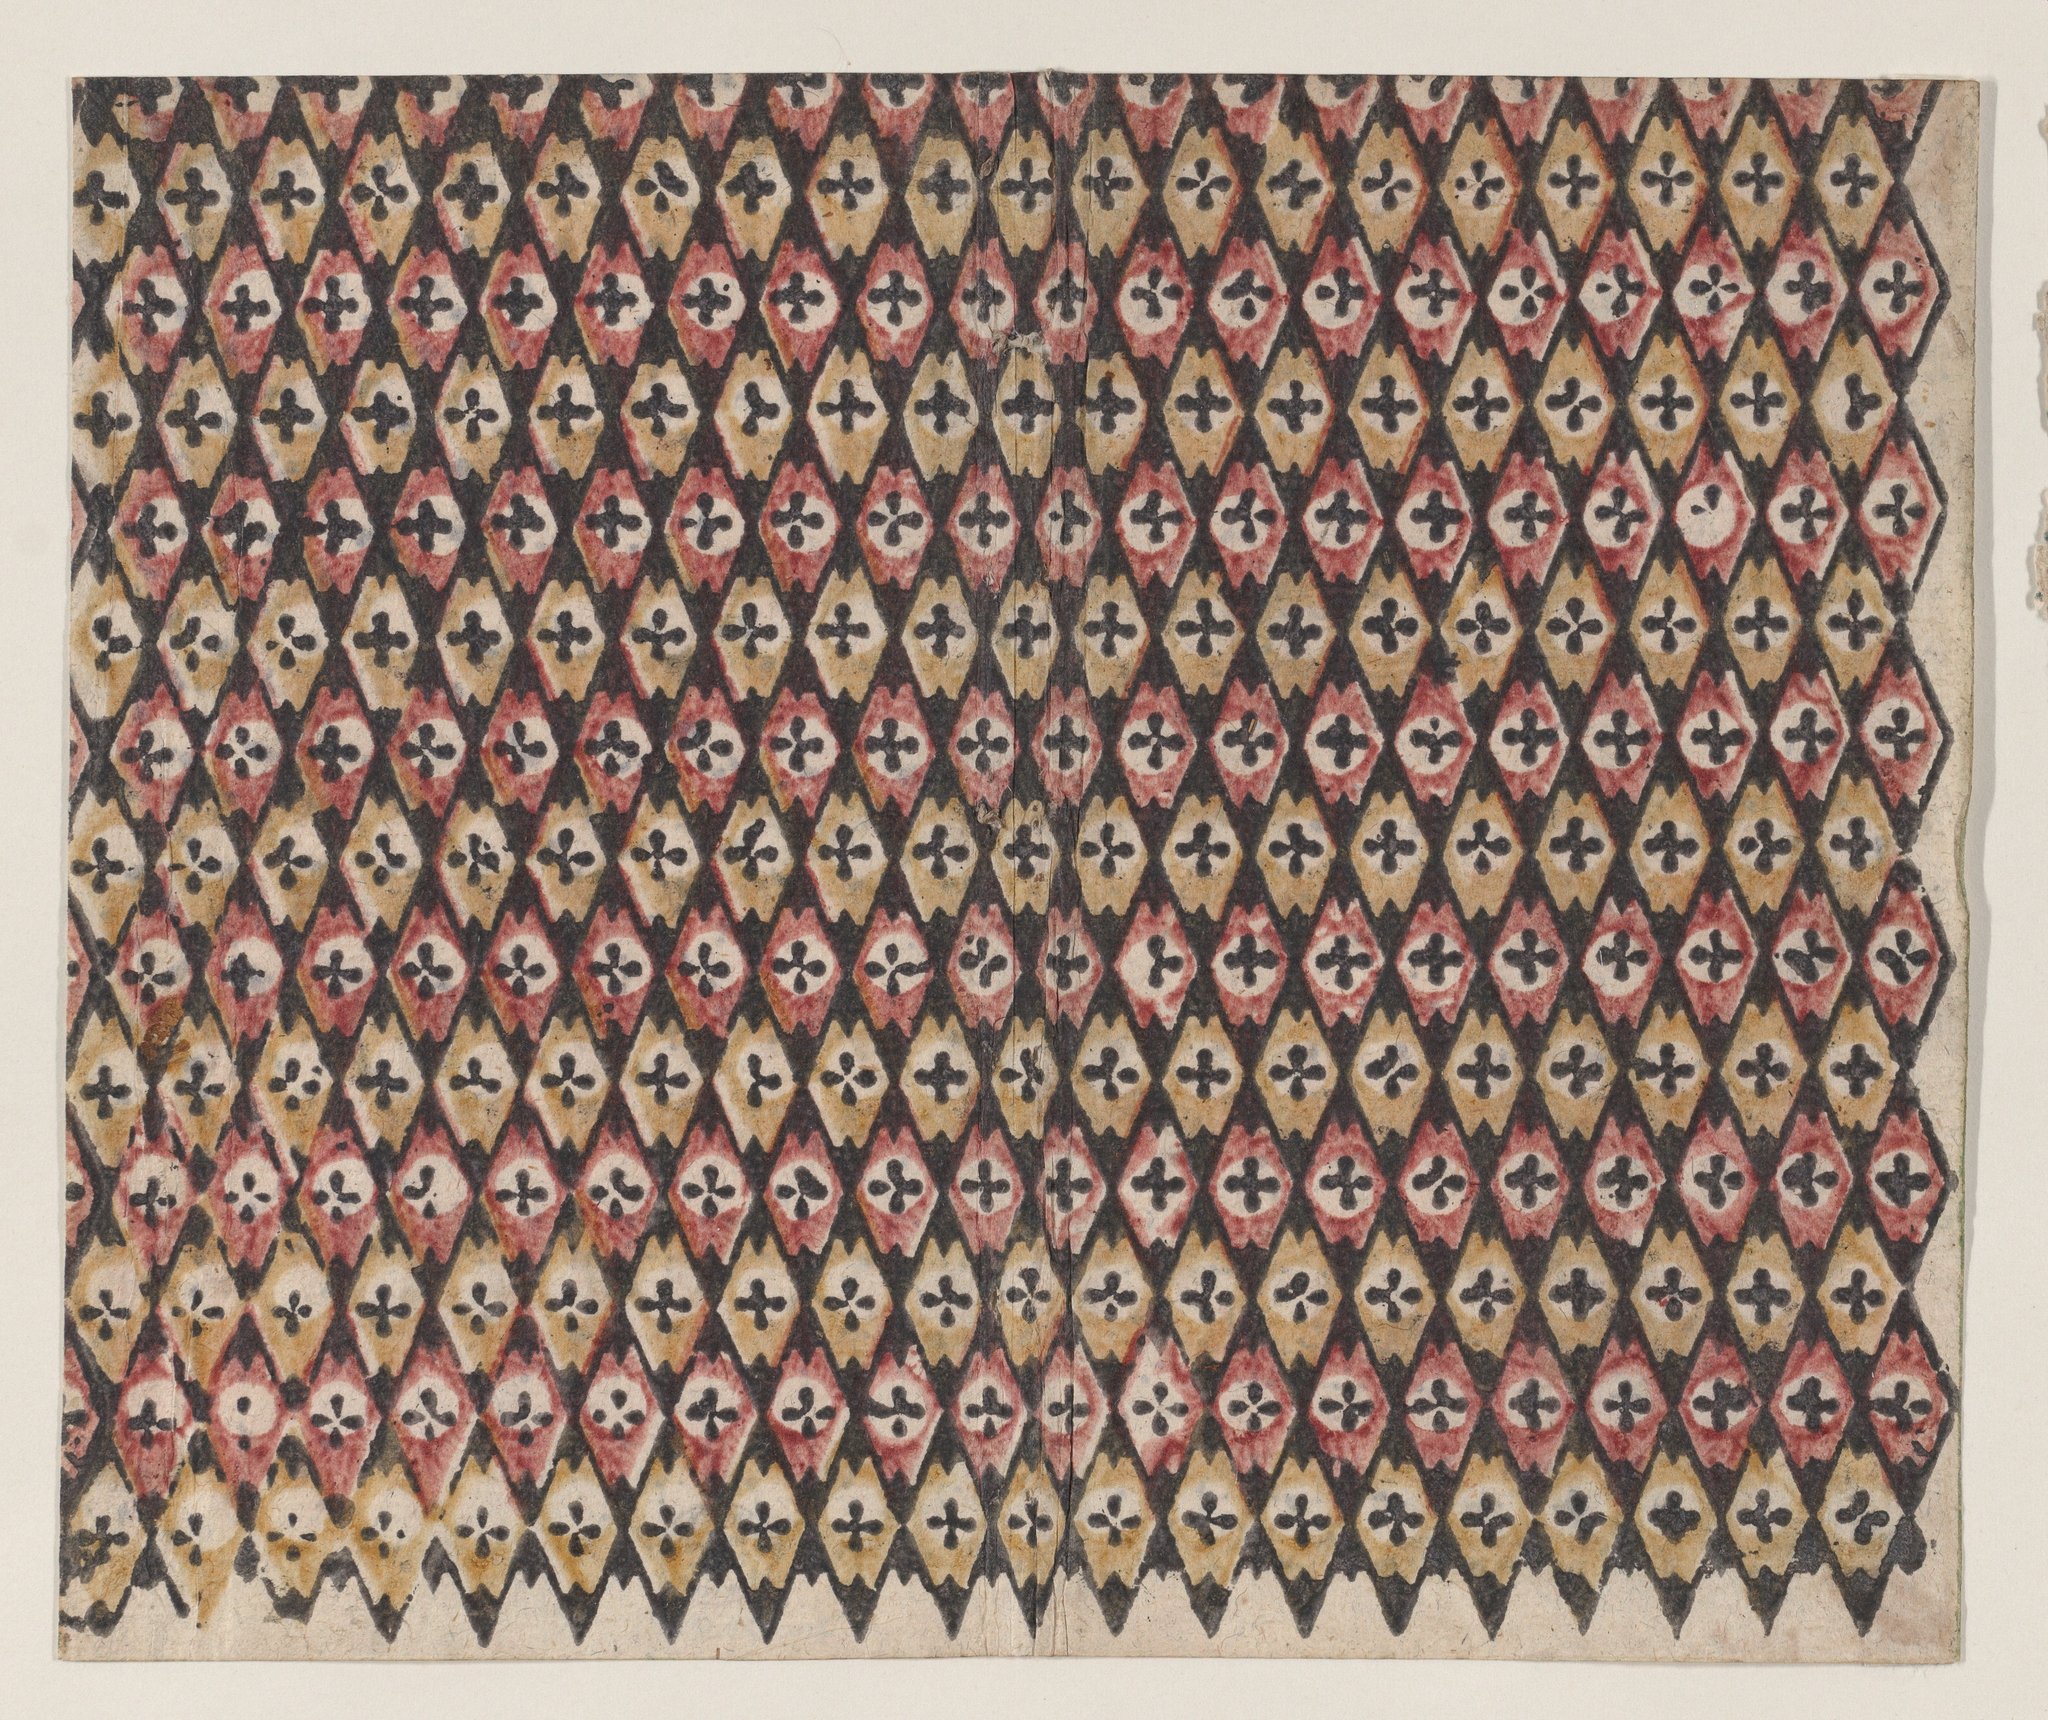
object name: print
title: Sheet with overall diamond pattern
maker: Anonymous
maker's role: artist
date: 1801-1900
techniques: relief print